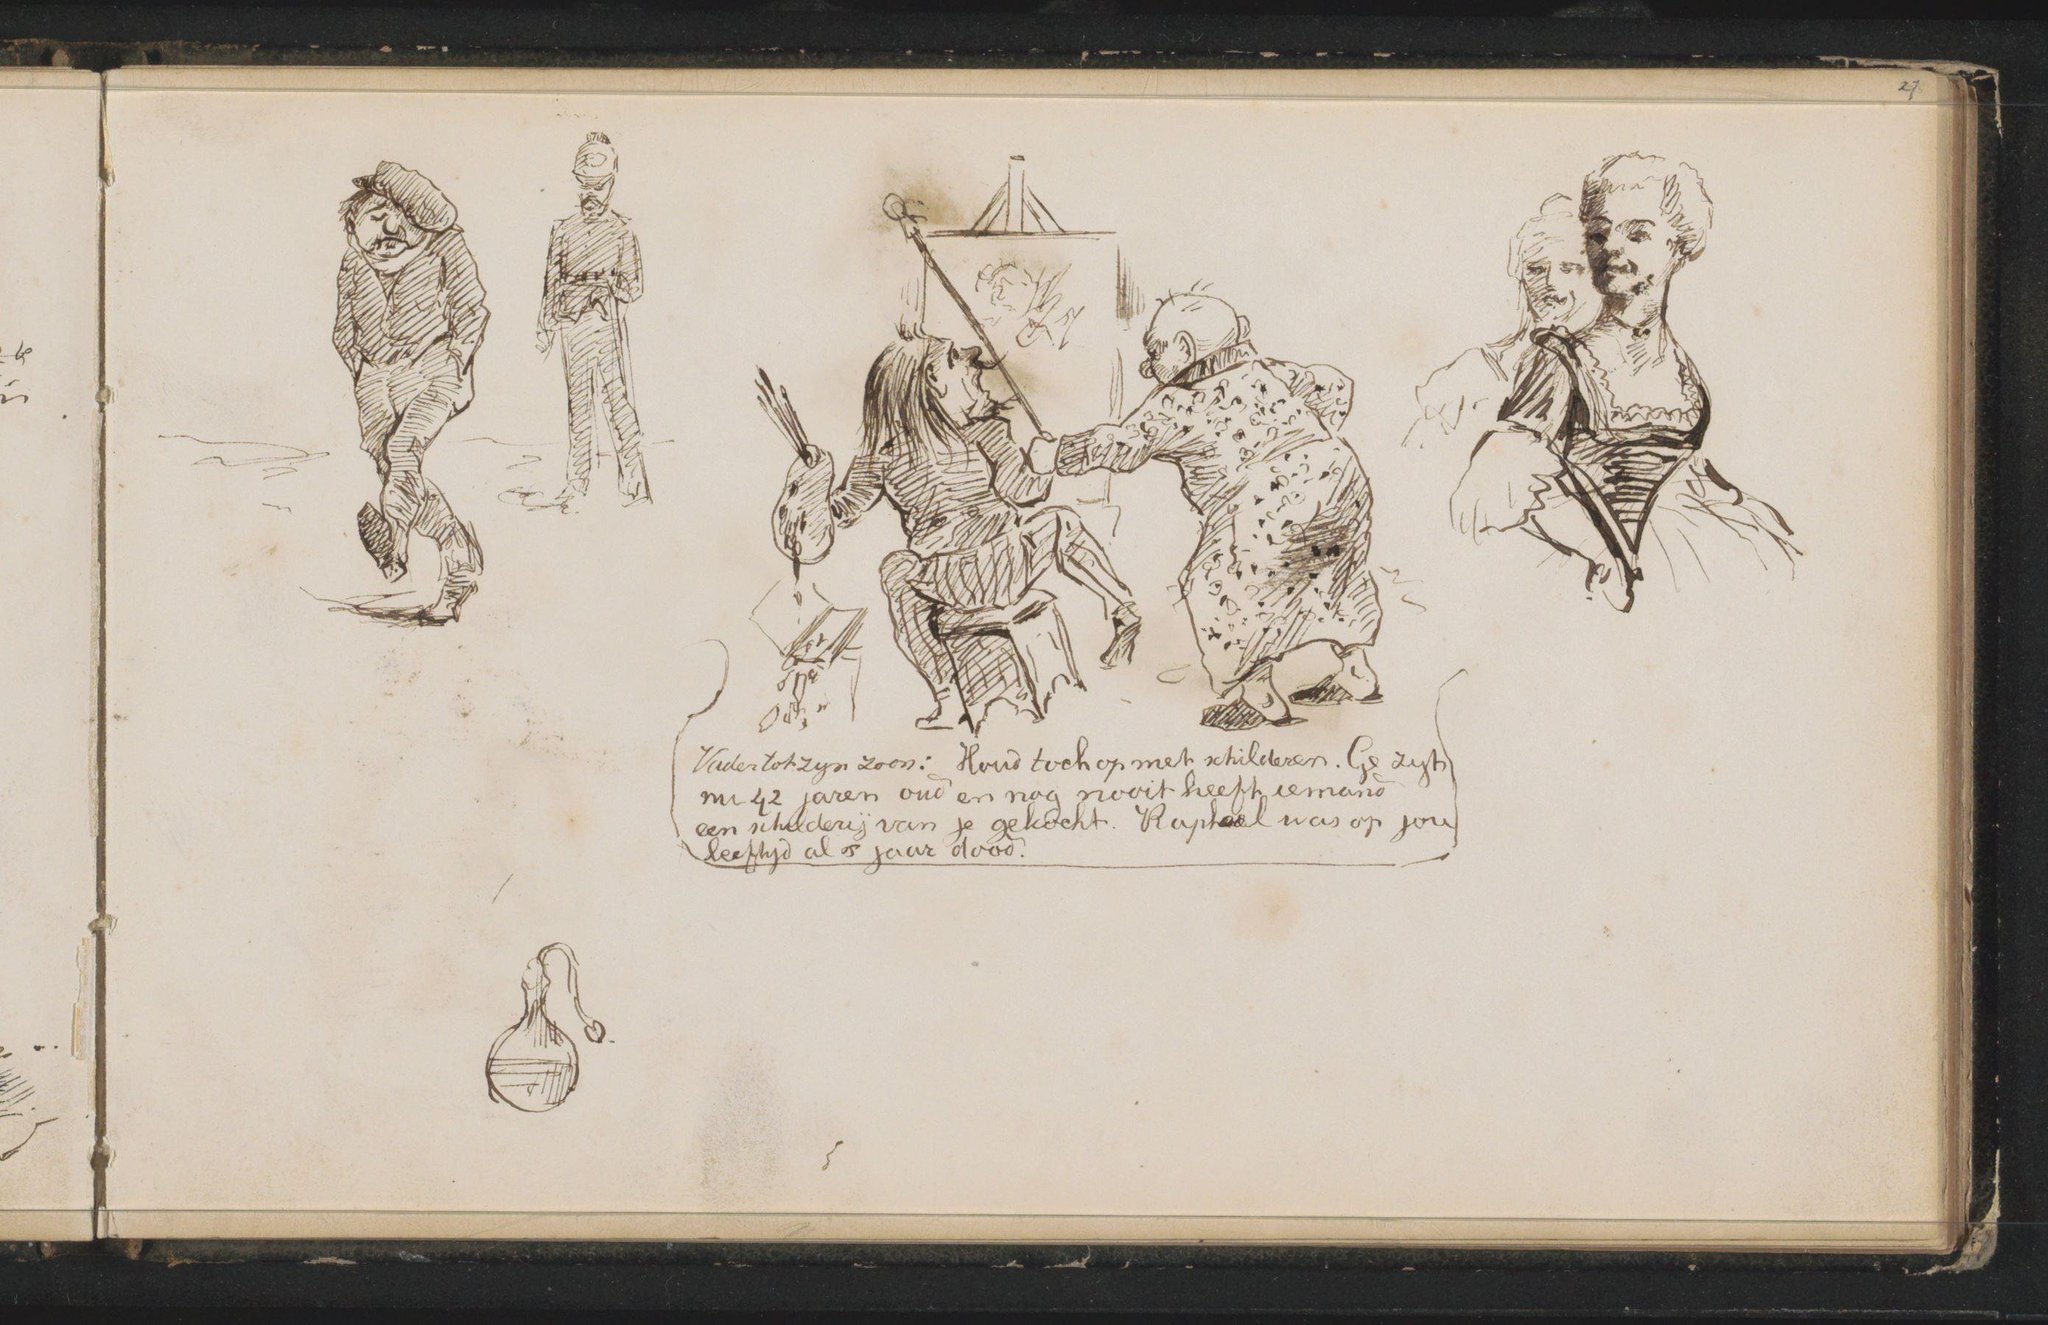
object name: sketchbook leaf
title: Karikatuur van de schilderkunst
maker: marius bauer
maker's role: draughtsman, print maker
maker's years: 1867-1932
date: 1812-1880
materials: paper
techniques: pen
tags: perfume bottle, adult woman, adult man, workshop, studio ~ painter, tools, implements of painter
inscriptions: annotation: ‘Vader tot zijn Zoon: Houd toch op met schilderen. Ge zijt/ nu 42 jaren oud en nog nooit heeft iemand/ een schilderij van je gekocht. Raphael was op jou/ leeftijd al 5 jaar dood.’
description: Tevens een figuurstudie van mannen en een vrouw en een studie van een parfumfles. Pagina 27 uit een schetsboek met 34 bladen.